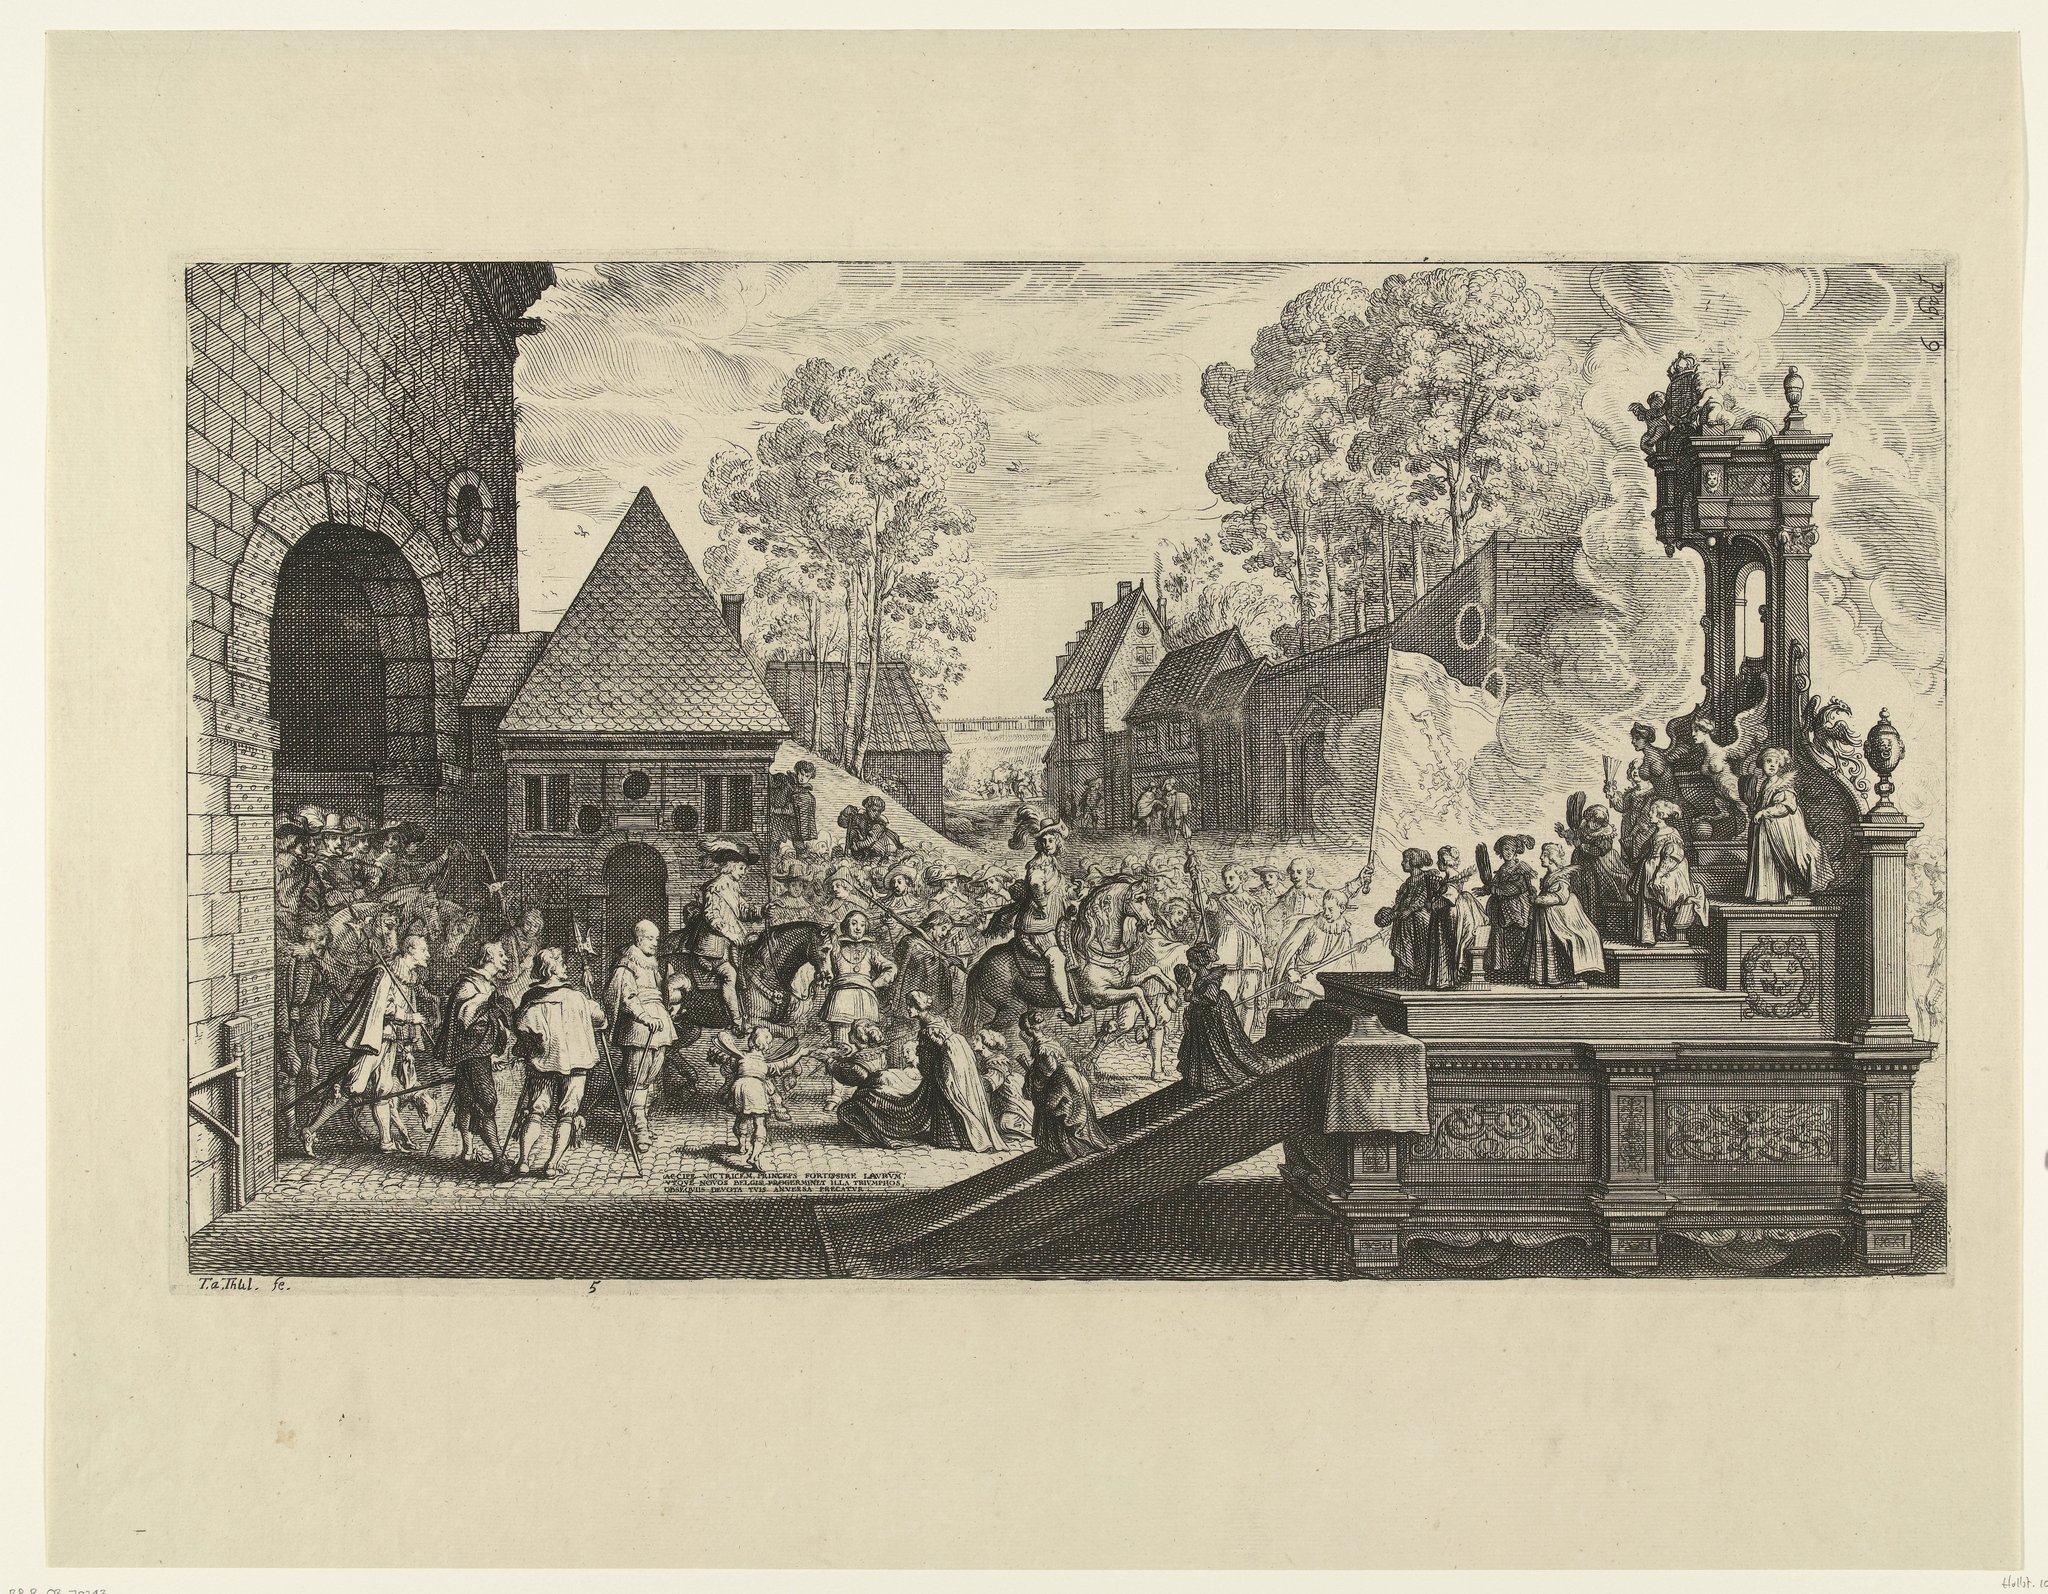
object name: print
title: Laurea Serenissimo Principa oblata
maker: theodoor van thulden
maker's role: draughtsman, painter, print maker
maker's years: 1606-1669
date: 1639-1641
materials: paper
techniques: engraving, etching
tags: brussels, landvoogd der zuidelijke nederlanden ferdinand van oostenrijk, triumphal entry and public reception, pageant, 'entrée solennelle', 'joyeuse entrée', antwerp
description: Aankomst van de stoet binnen de stad. Ferdinand te paard wordt verwelkomd door vrouwen met een lauwerkrans. Rechts een praalwagen met allegorische vrouwenfiguren, waarschijnlijk provinciemaagden. Gemerkt rechtsboven: pag. 9. Blad nr. 5 in een geheel van 43 platen die de uitgave van de beschrijving van de intocht van de Kardinaal Infant Ferdinand van Oostenrijk te Antwerpen op 17 april 1635 als de nieuwe landvoogd voor de Spaanse Nederlanden illustreren.